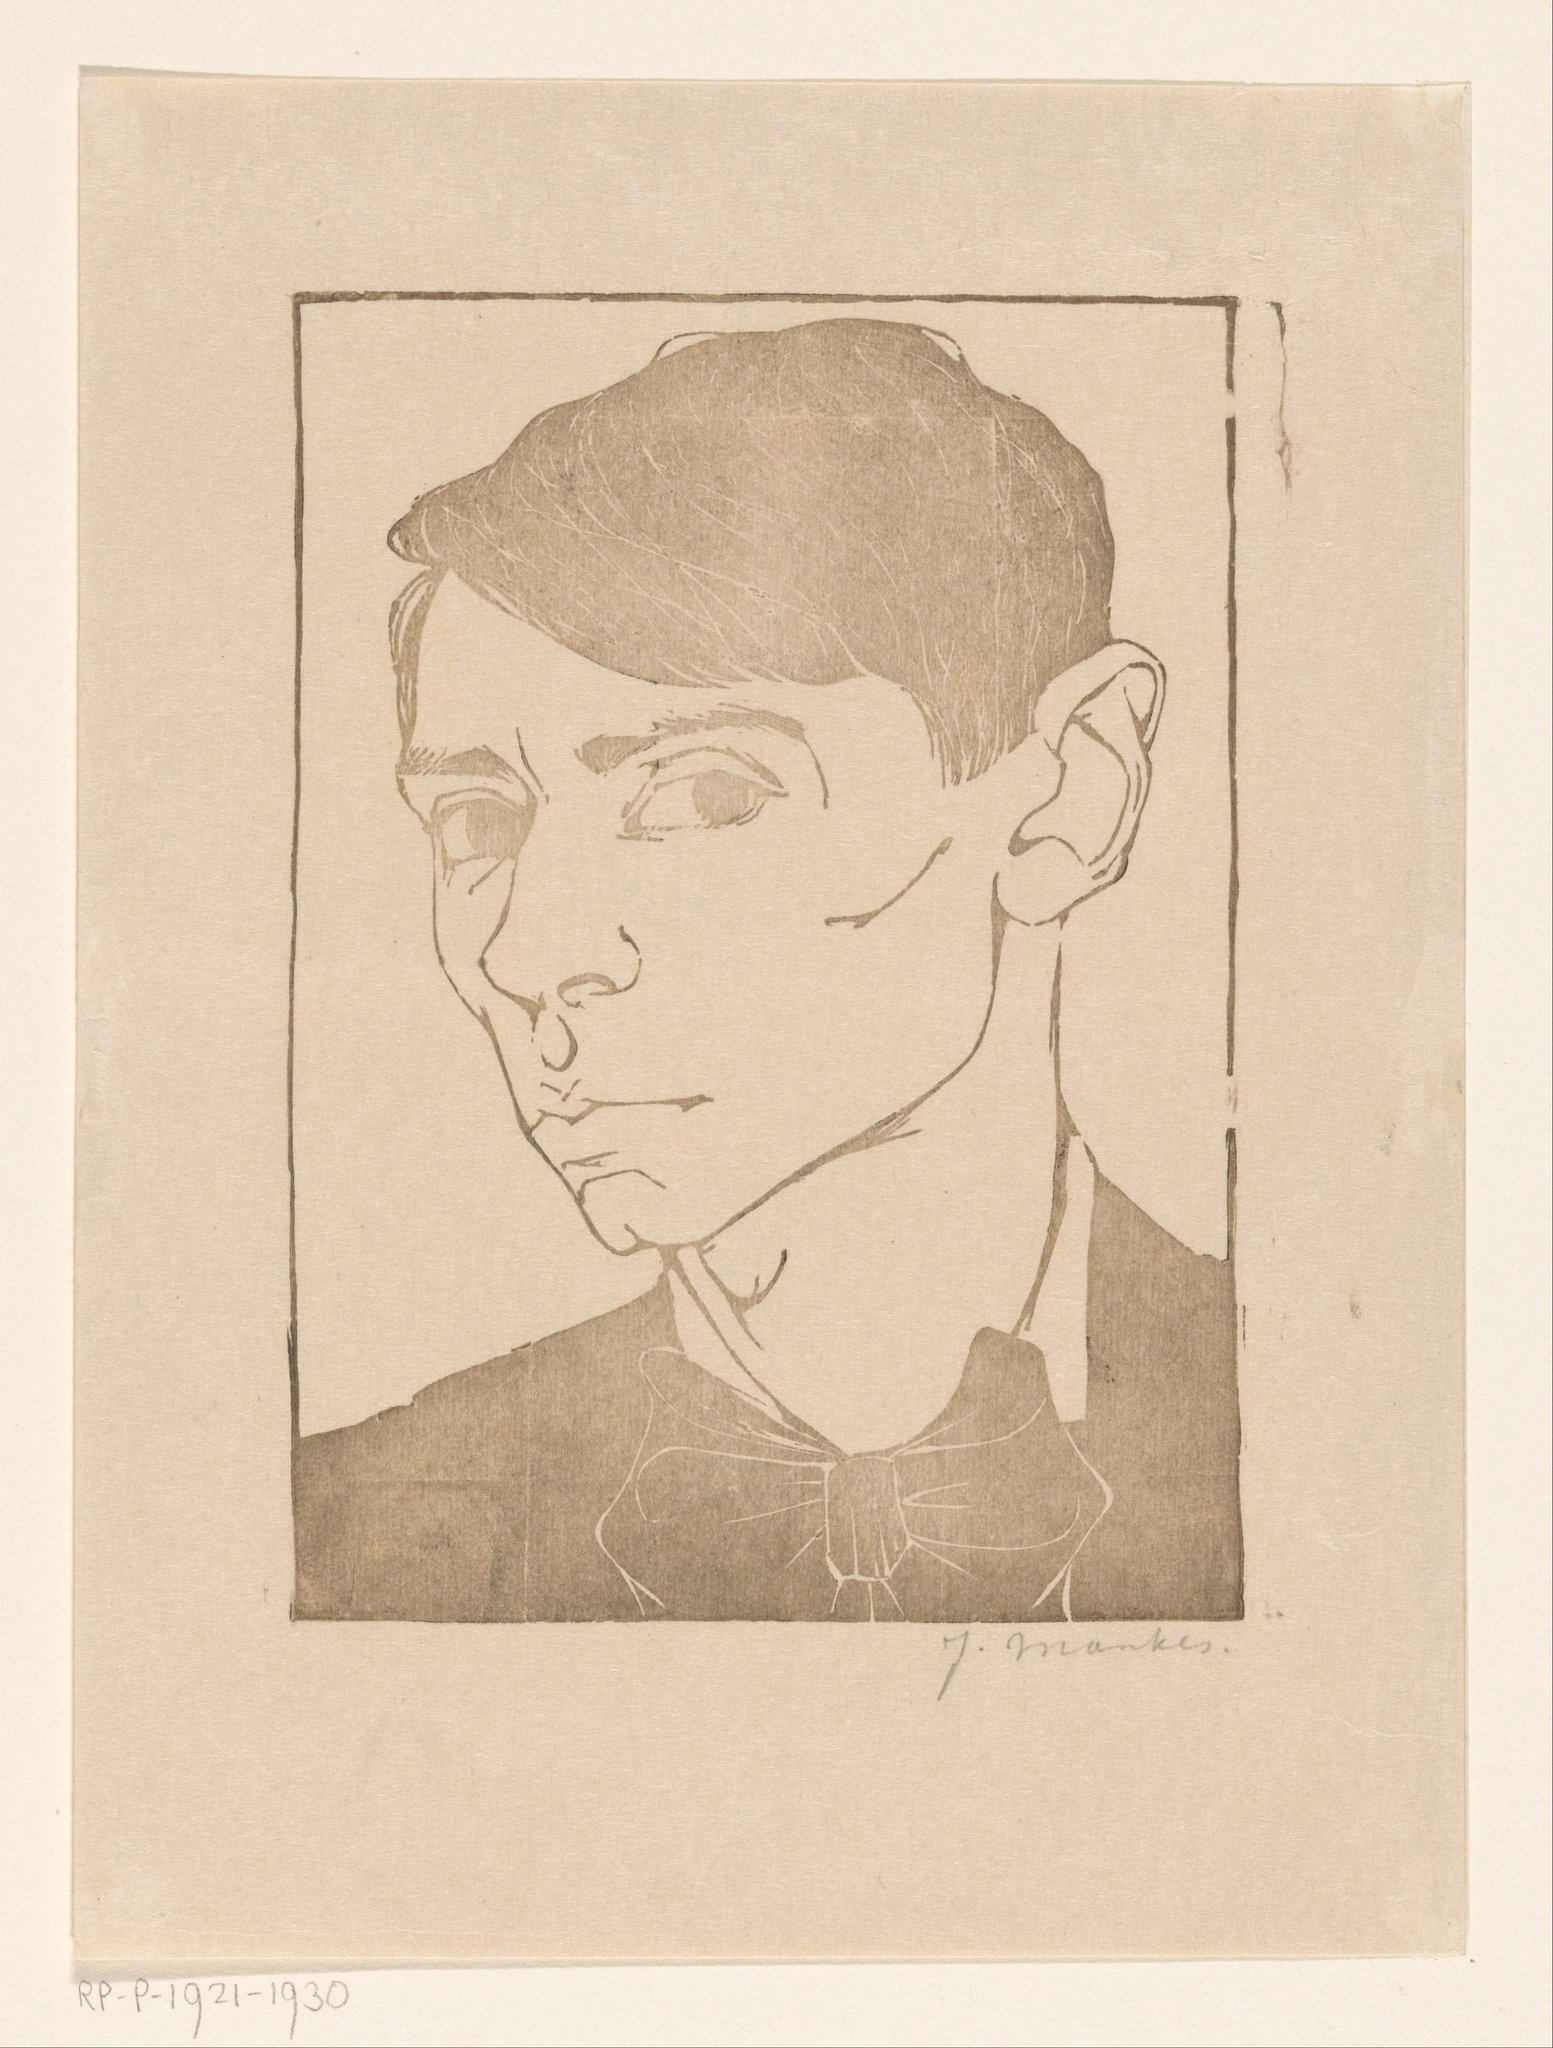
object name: print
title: Zelfportret met vlinderdas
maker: jan mankes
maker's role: draughtsman, painter, print maker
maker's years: 1889-1920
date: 1913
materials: paper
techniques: woodcut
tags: painter, jan mankes, neck-gear ~ clothing (with name), portrait, self-portrait of artist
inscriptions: collector's mark: Lugt 2228